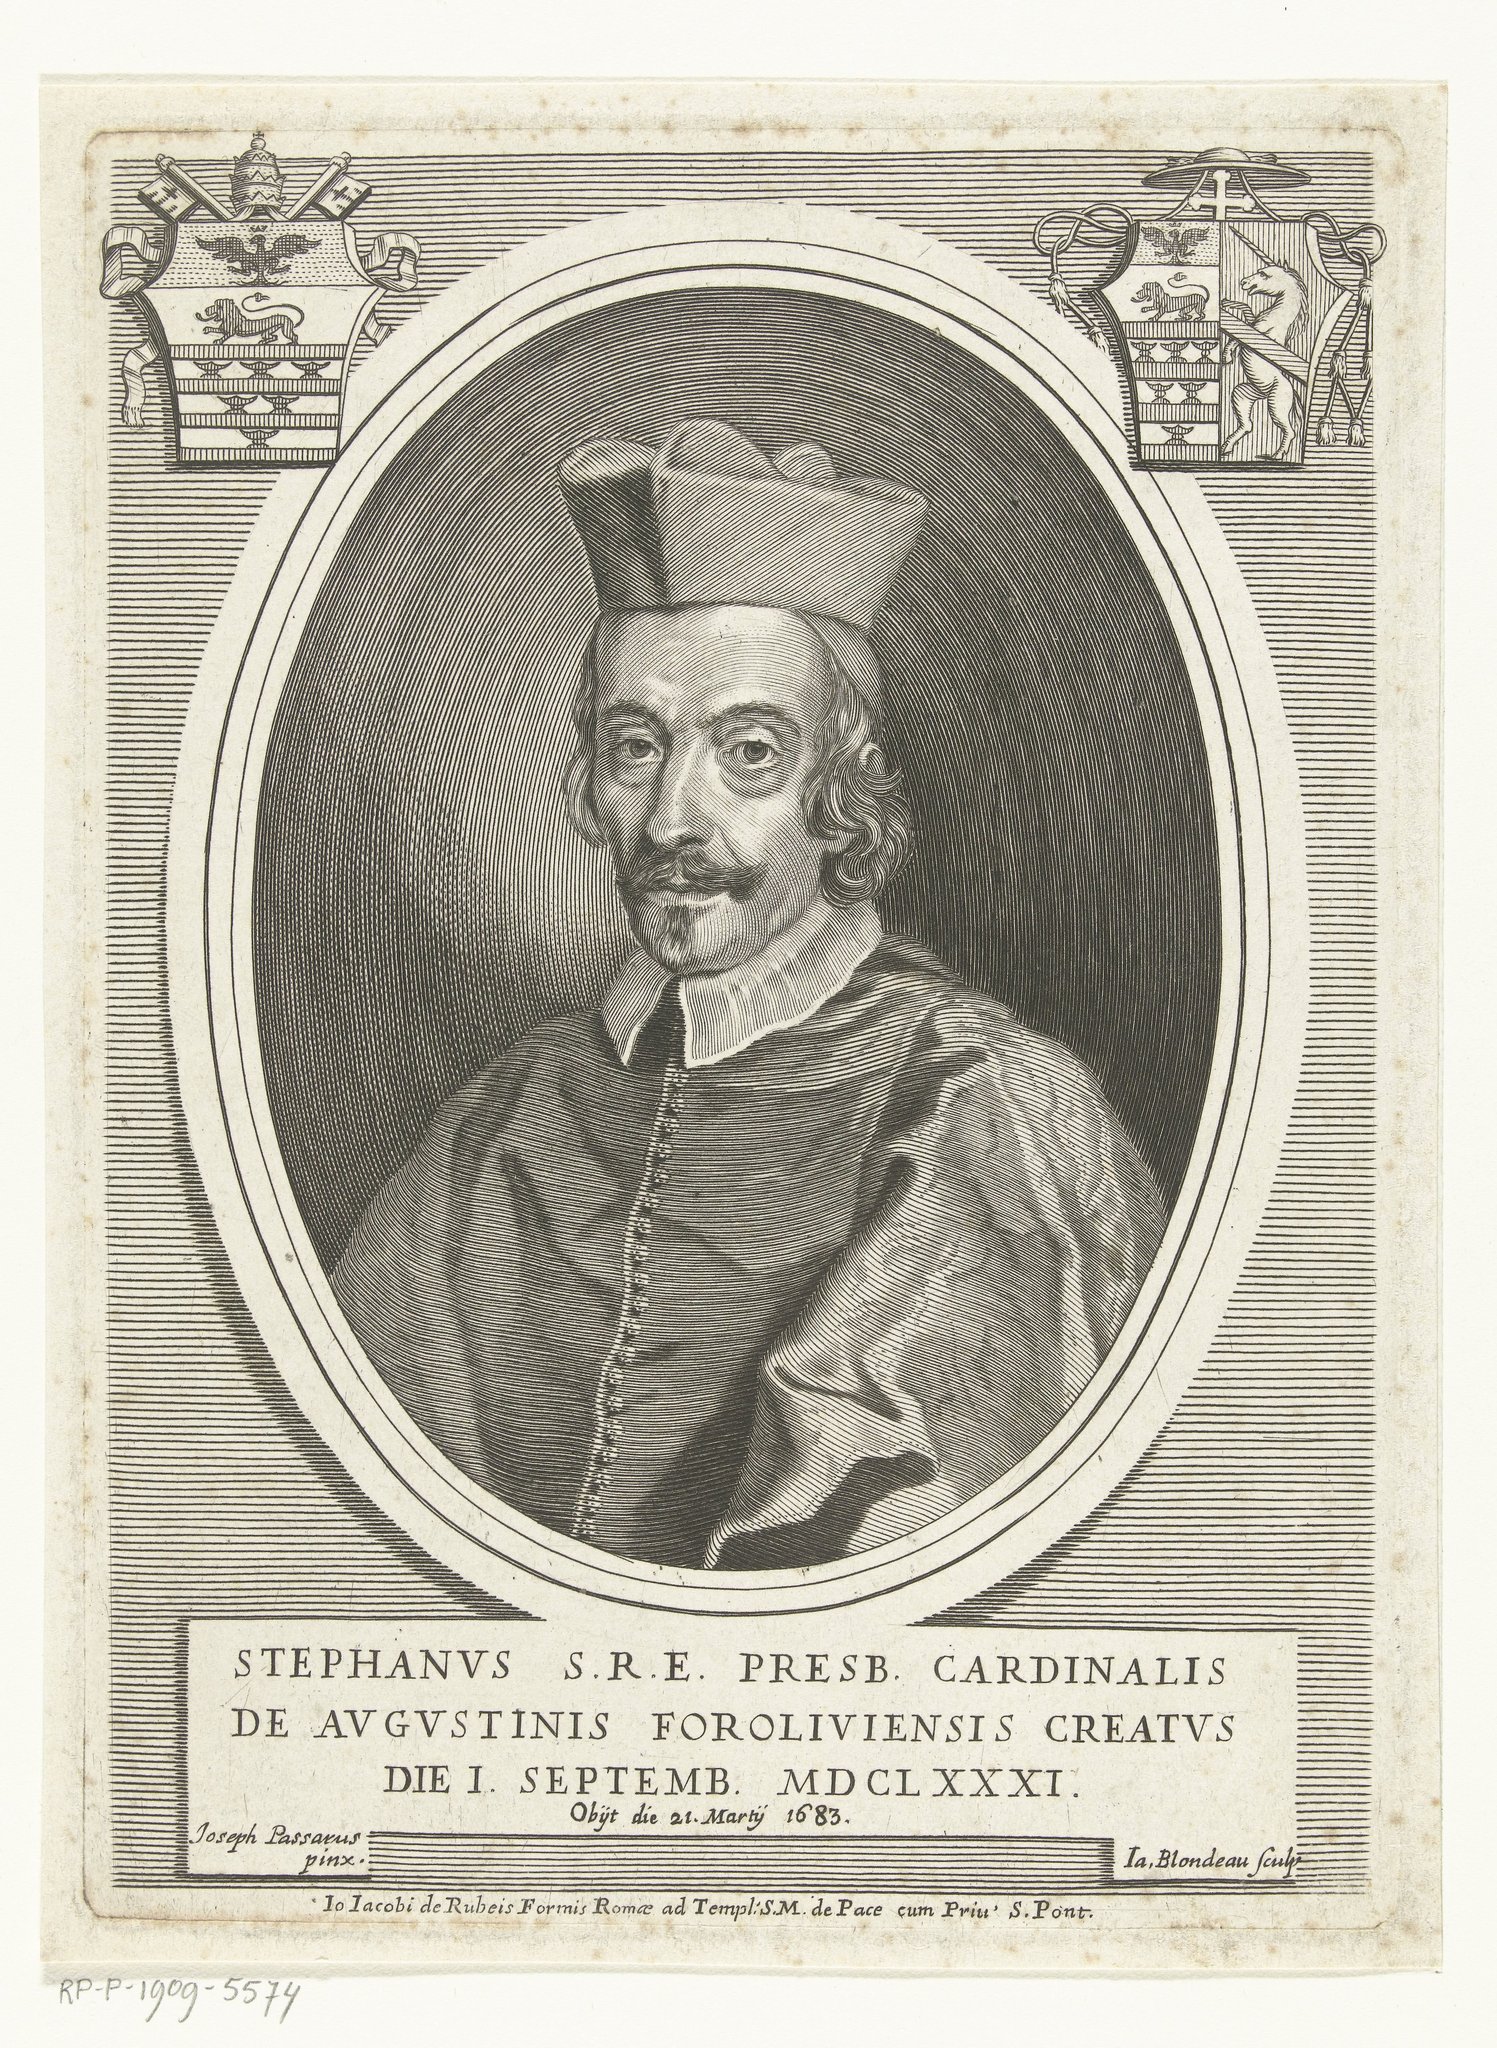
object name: print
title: Portret van kardinaal Stefano Agostini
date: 1683-1698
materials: paper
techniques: engraving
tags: forli, stefano agostini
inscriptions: collector's mark: Lugt 2228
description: Prent naar schilderij van Joseph Passari.